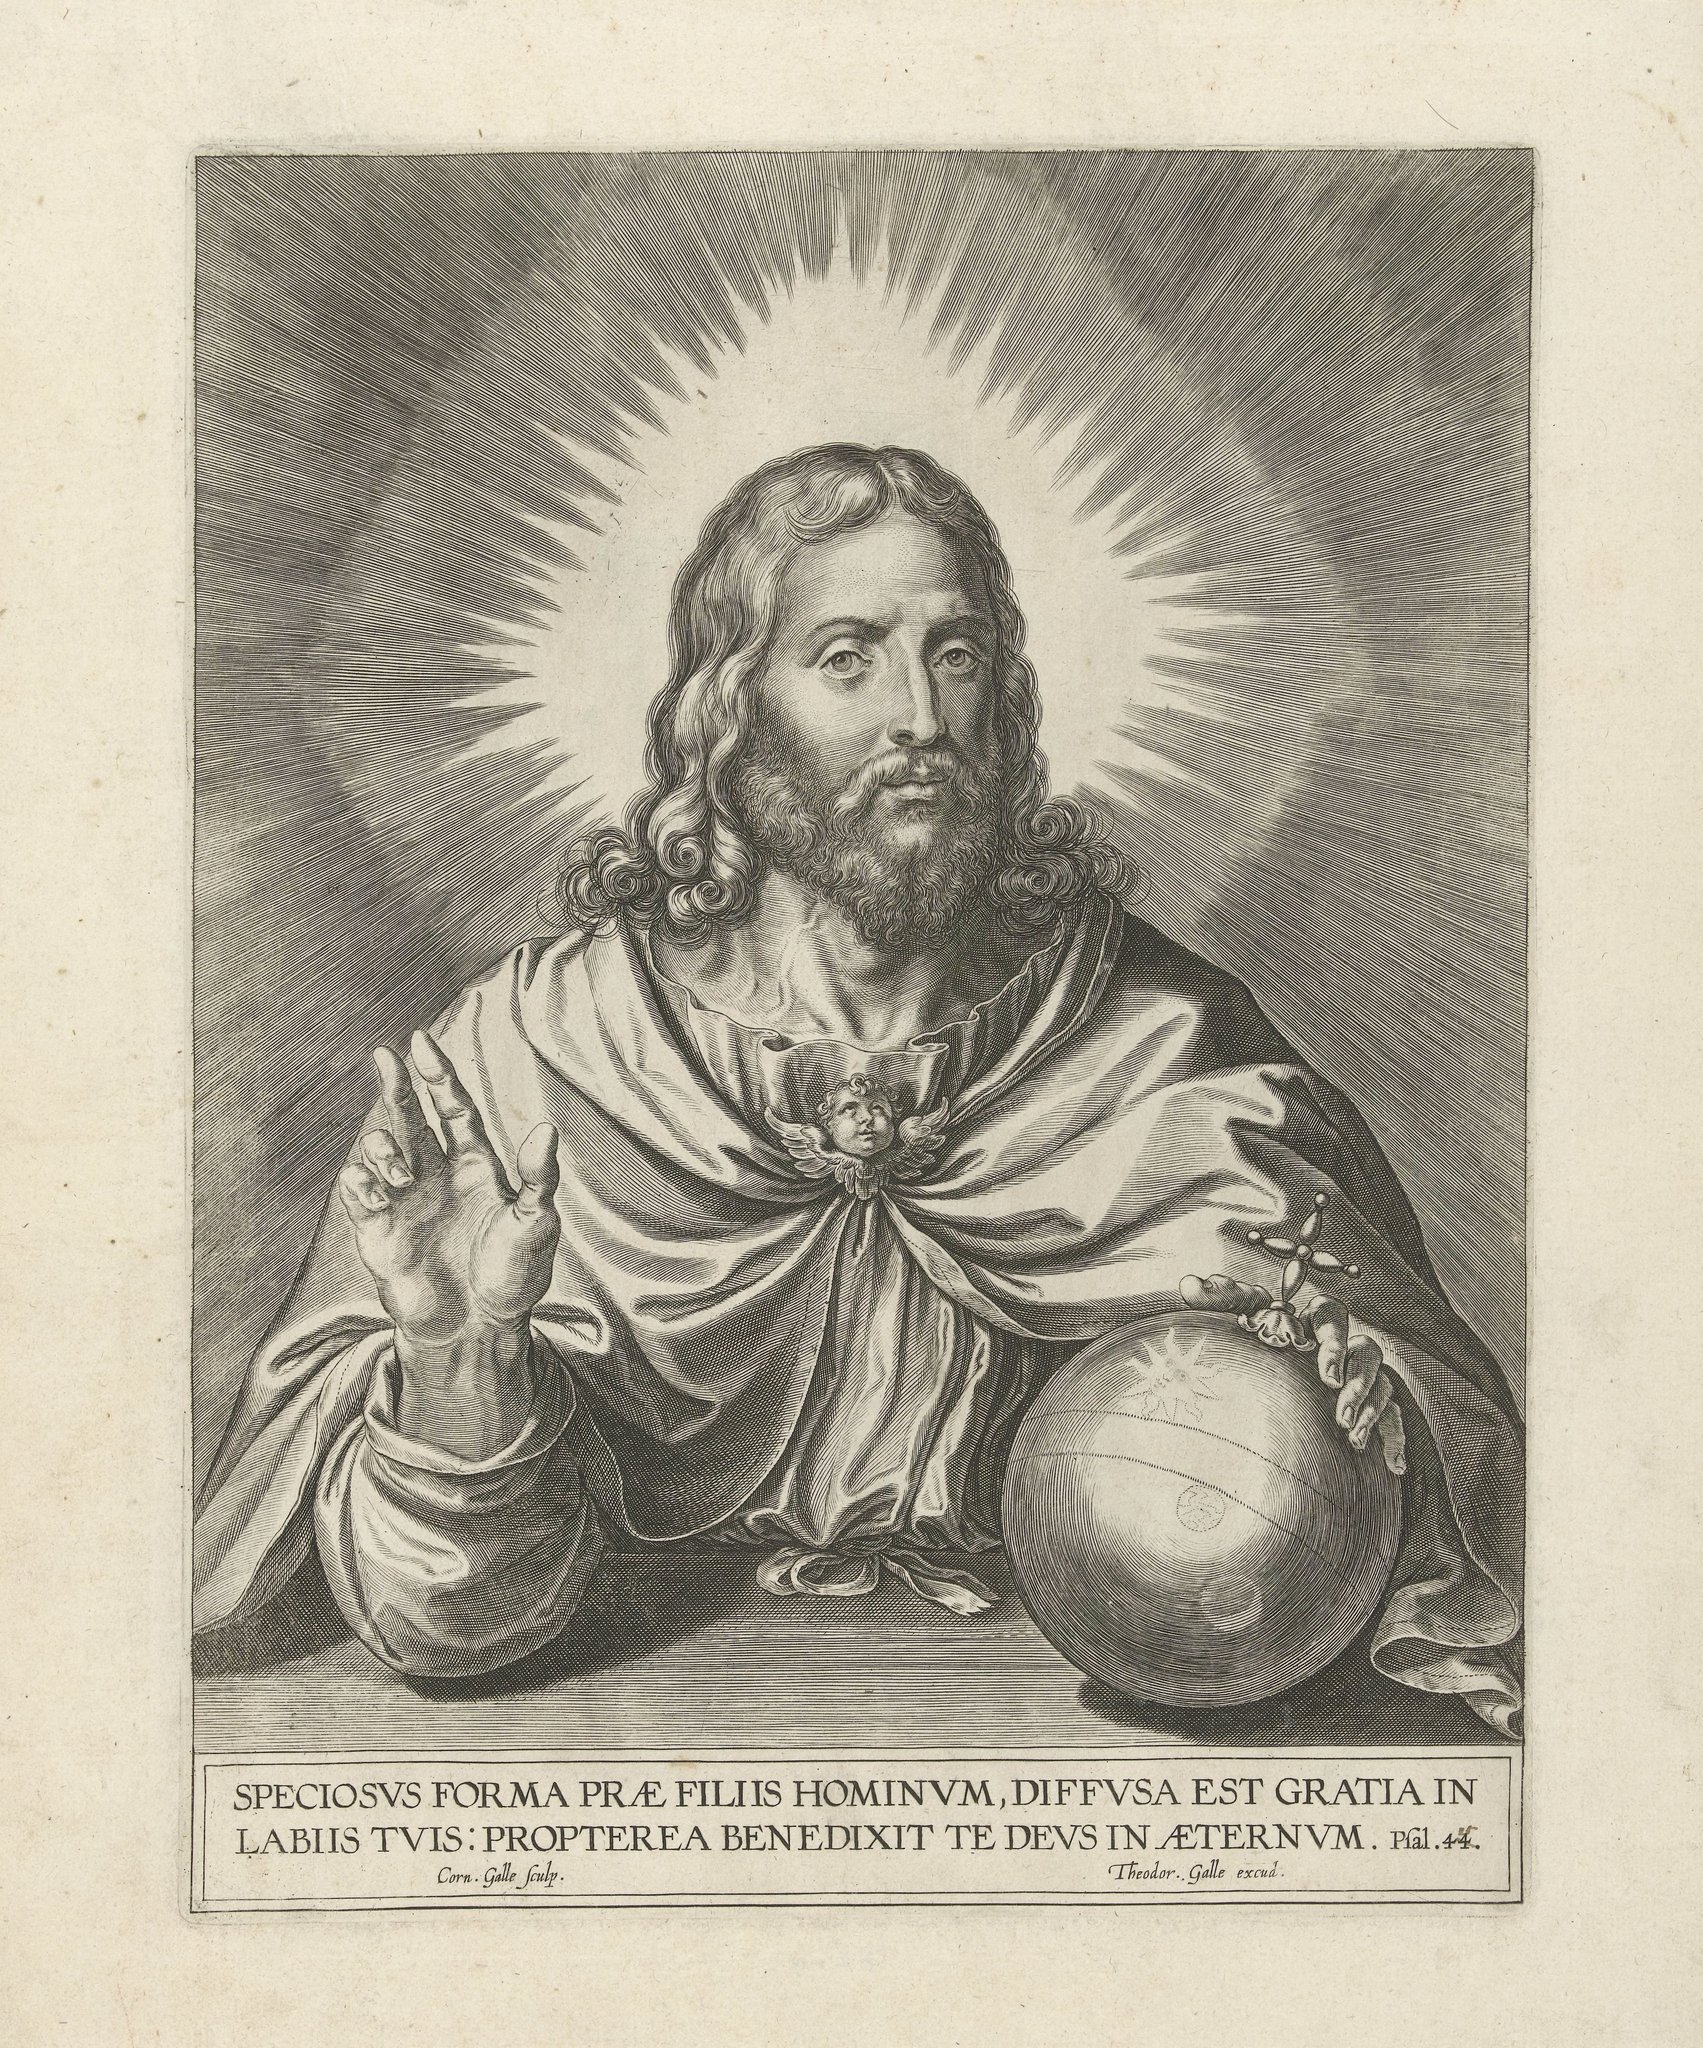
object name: print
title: Christus als Salvator Mundi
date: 1586-1633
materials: paper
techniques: engraving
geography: antwerp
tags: 'salvator mundi', making a blessing gesture; an orb in his hand or at his feet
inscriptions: collector's mark: Lugt 2228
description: Christus zittend aan een tafel. Met zijn rechterhand maakt hij een spreekgebaar, zijn linkerhand rust op een wereldbol. Onder de voorstelling een Latijns bijbelvers uit Psalm 44. Deze prent vormt een pendant met een prent van Cornelis Galle van de maagd Maria.